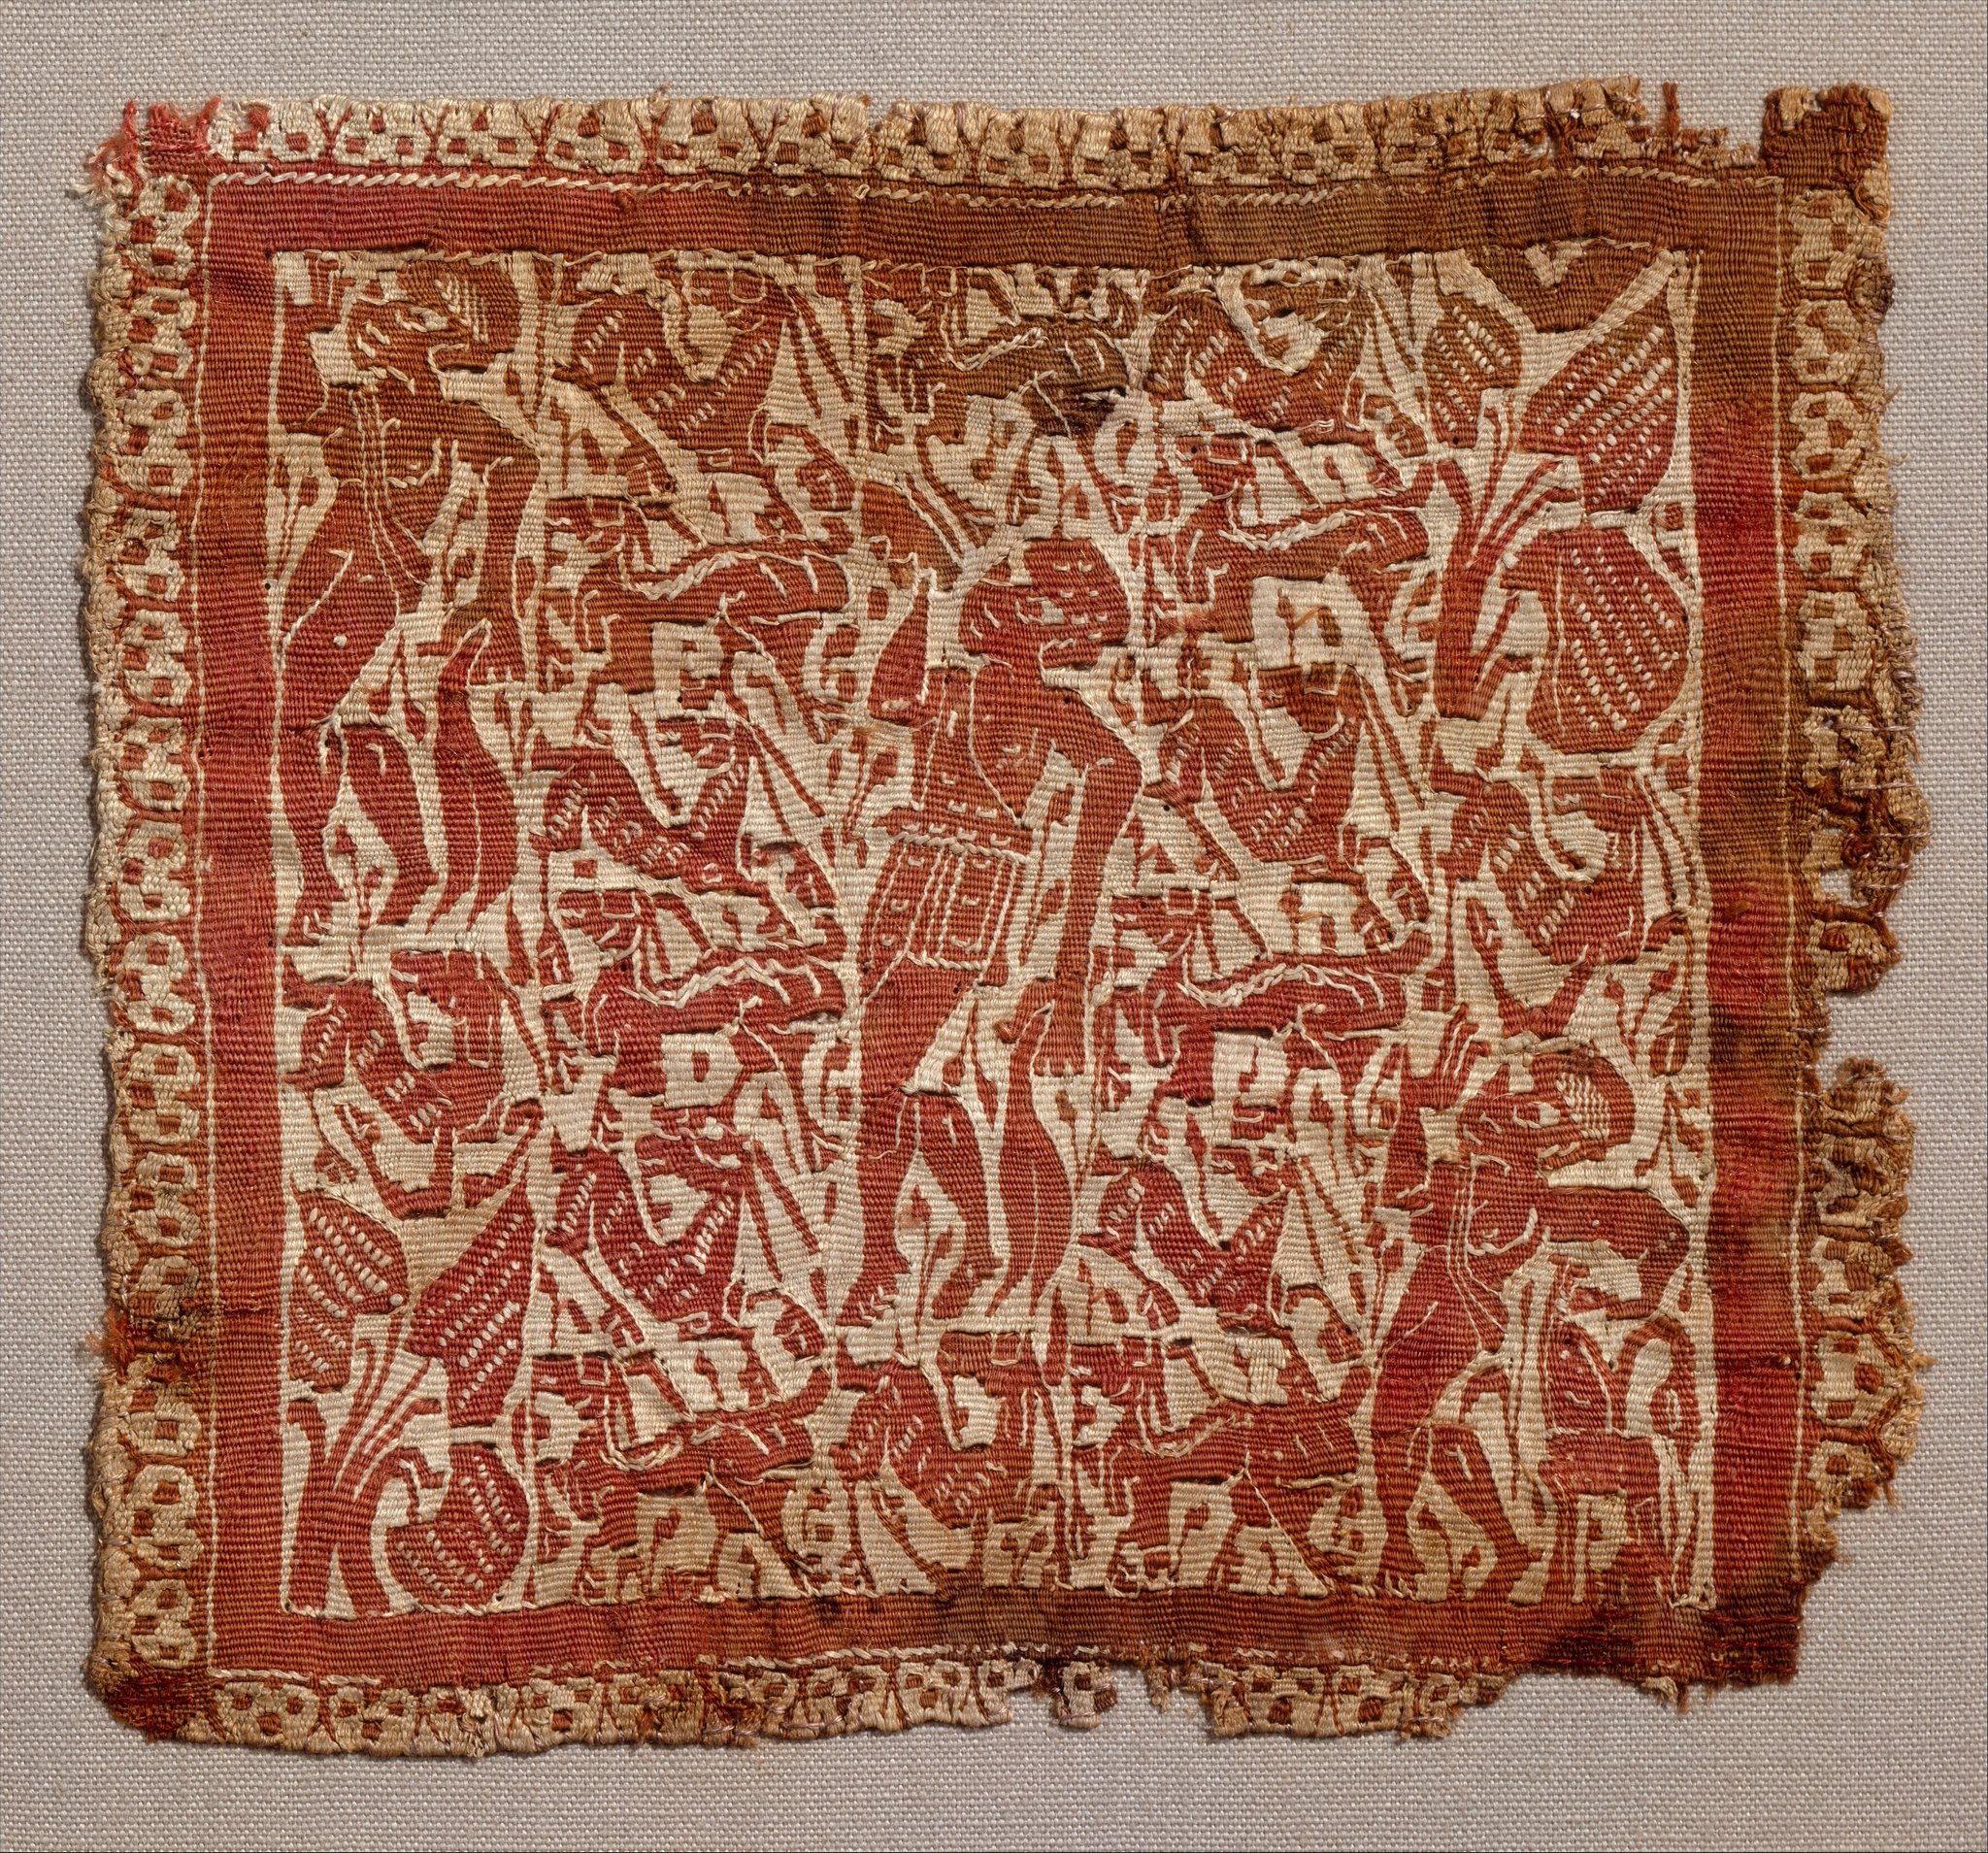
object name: square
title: Square with Bucolic Landscape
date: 301-600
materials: linen, wool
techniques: weave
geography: egypt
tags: dancing,shepherds